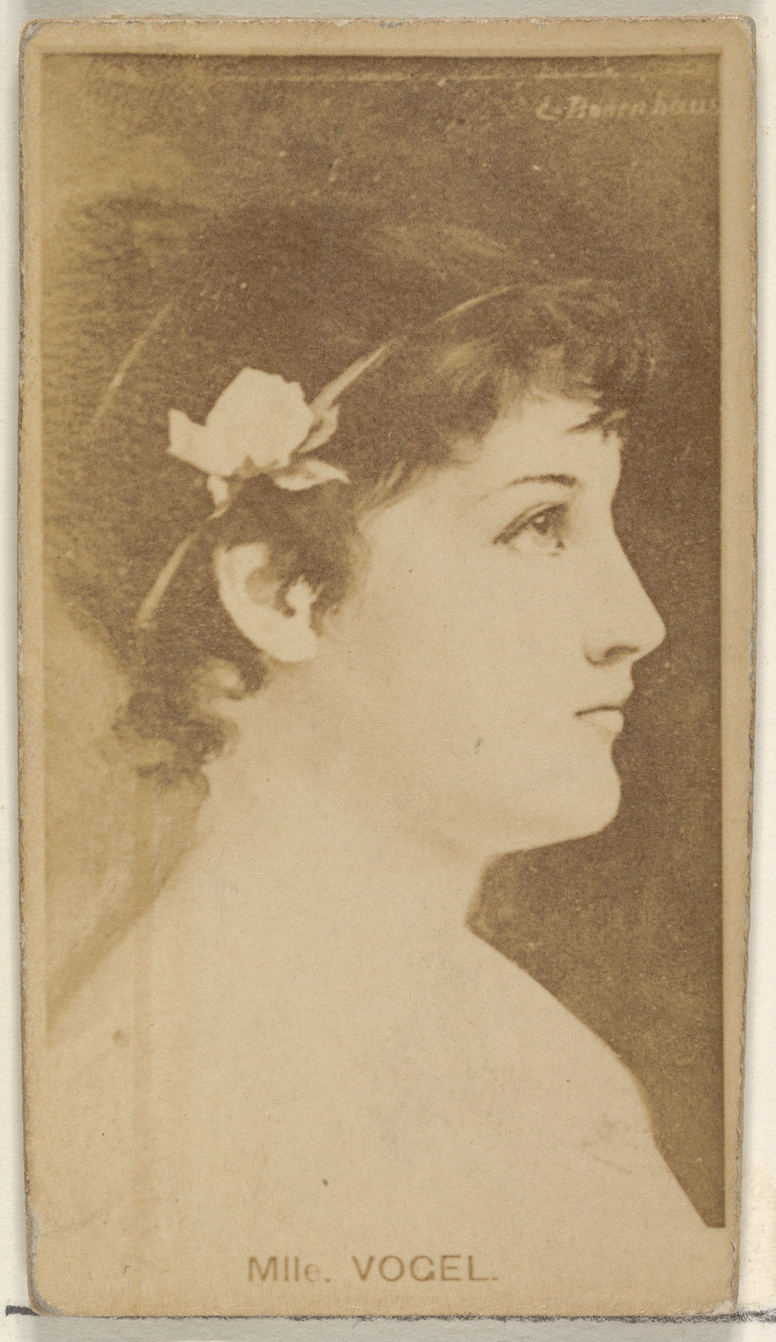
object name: photograph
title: Mlle. Vogel, from the Actors and Actresses series (N45, Type 8) for Virginia Brights Cigarettes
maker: allen & ginter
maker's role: publisher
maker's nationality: american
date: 1888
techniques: albumen silver print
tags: portraits,women,actresses